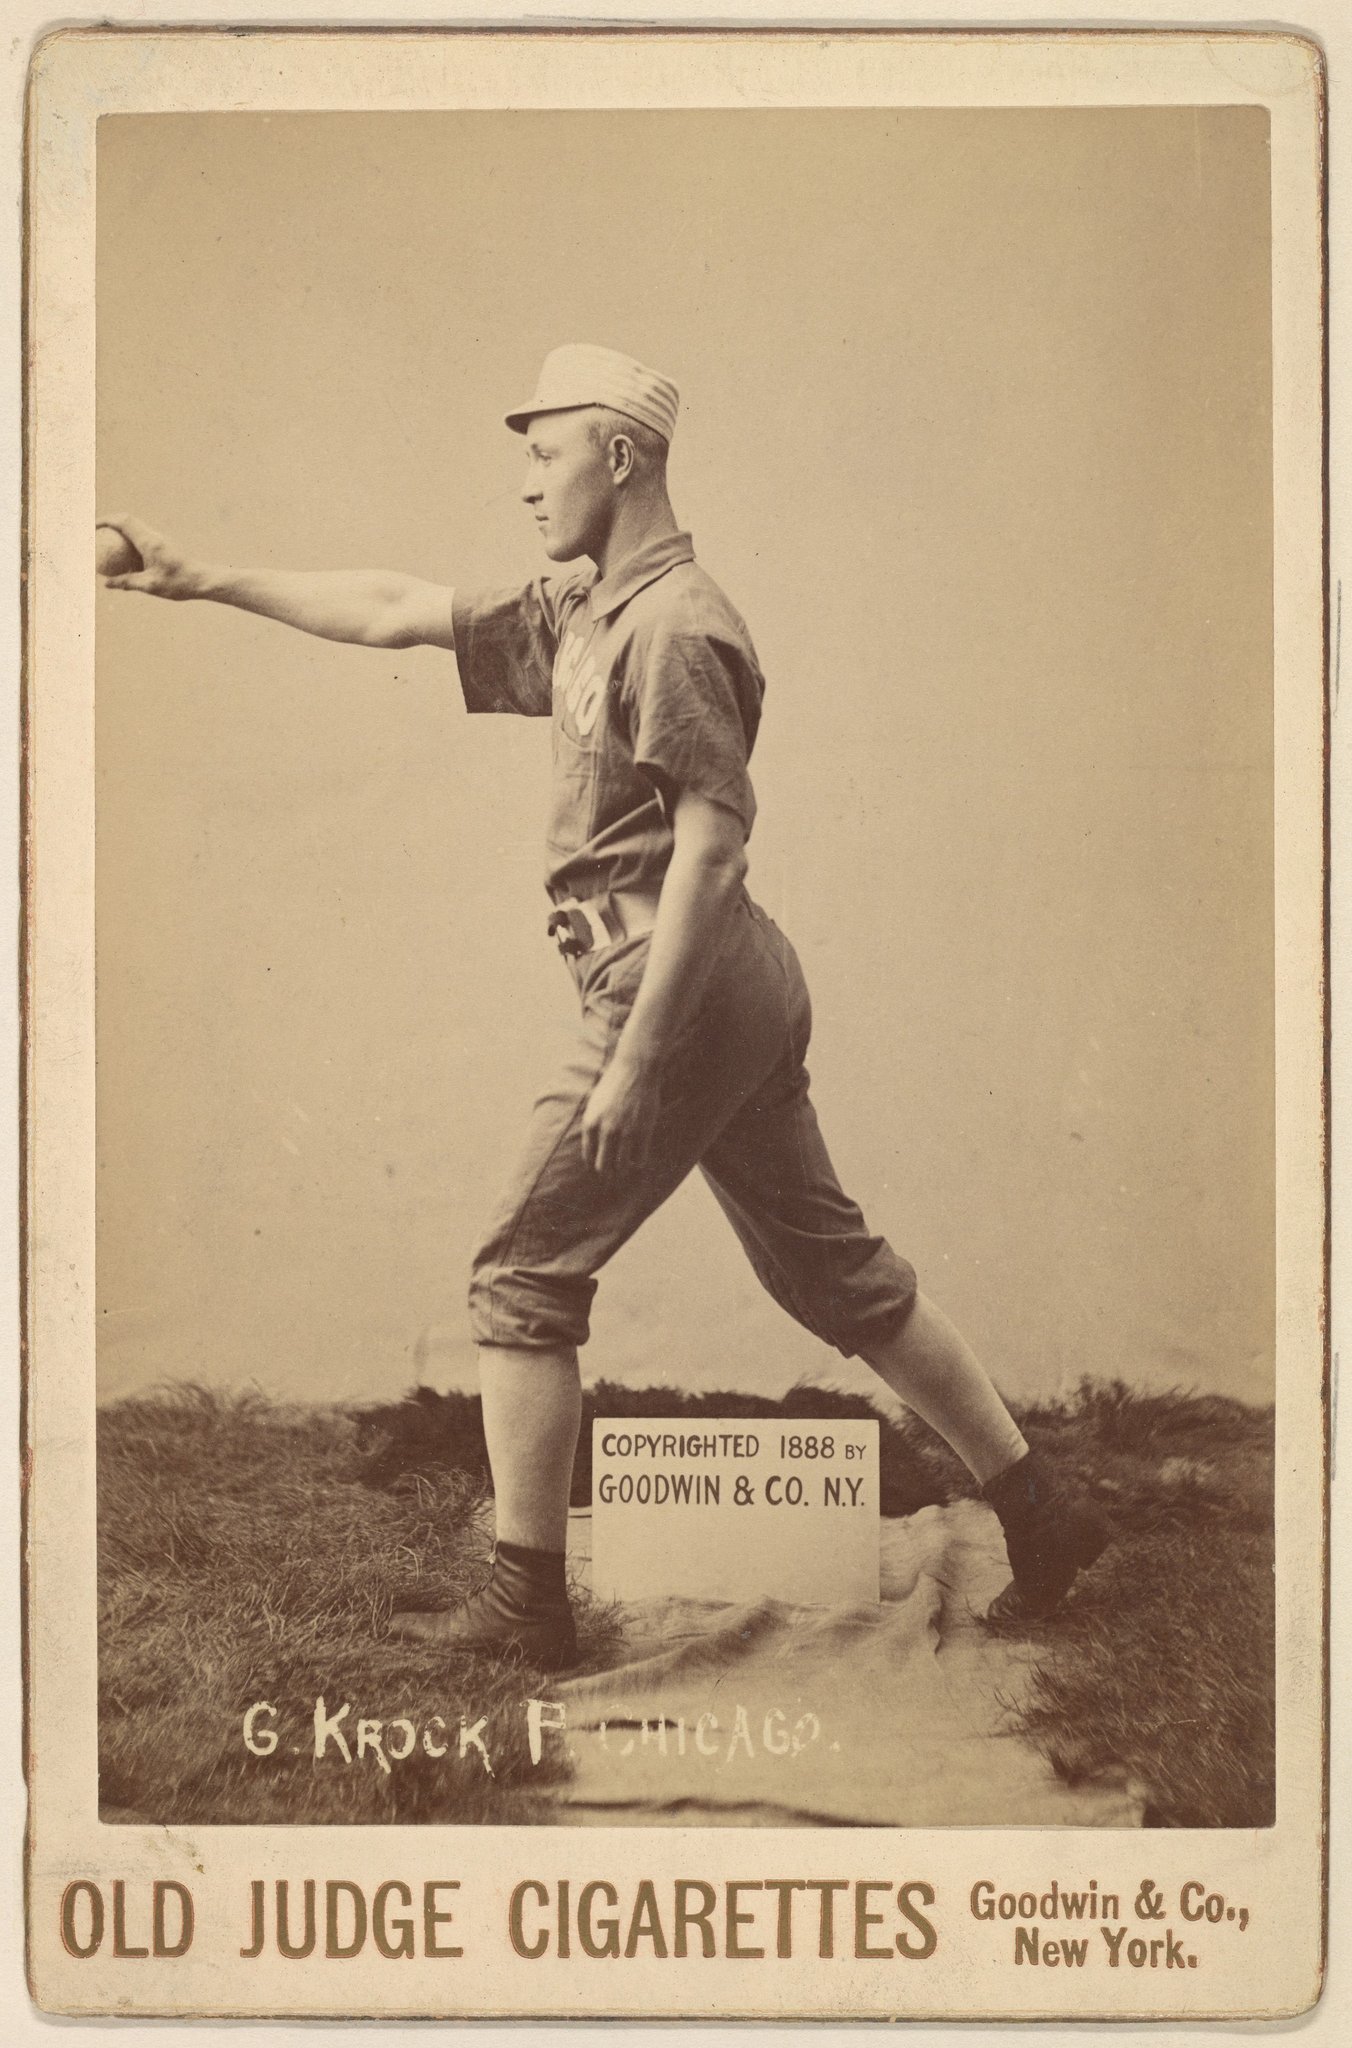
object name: baseball card, photograph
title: Gus Krock, Pitcher, Chicago, from the series Old Judge Cigarettes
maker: goodwin & company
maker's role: publisher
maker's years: 1850-1950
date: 1888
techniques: albumen silver print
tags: men,portraits,baseball,athletes